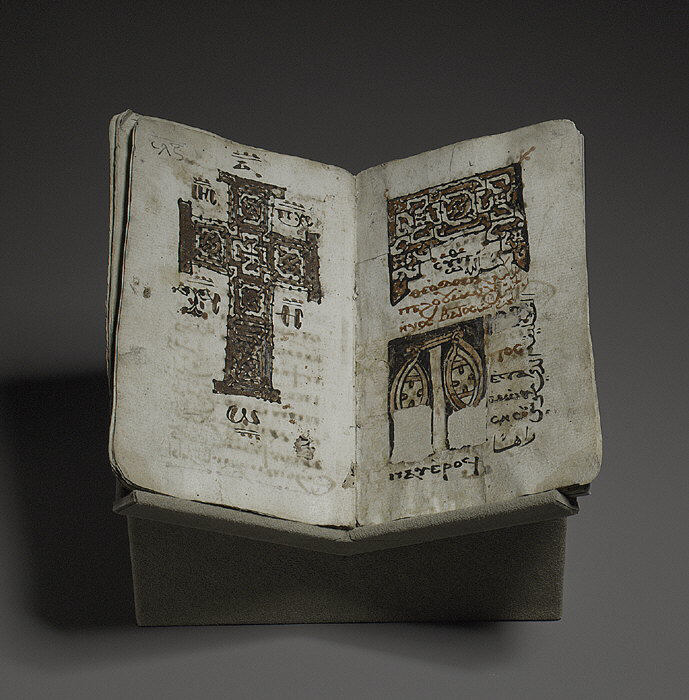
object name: illustrated manuscript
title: Coptic Liturgical Codex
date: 1601-1800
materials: ink, paper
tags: coptic